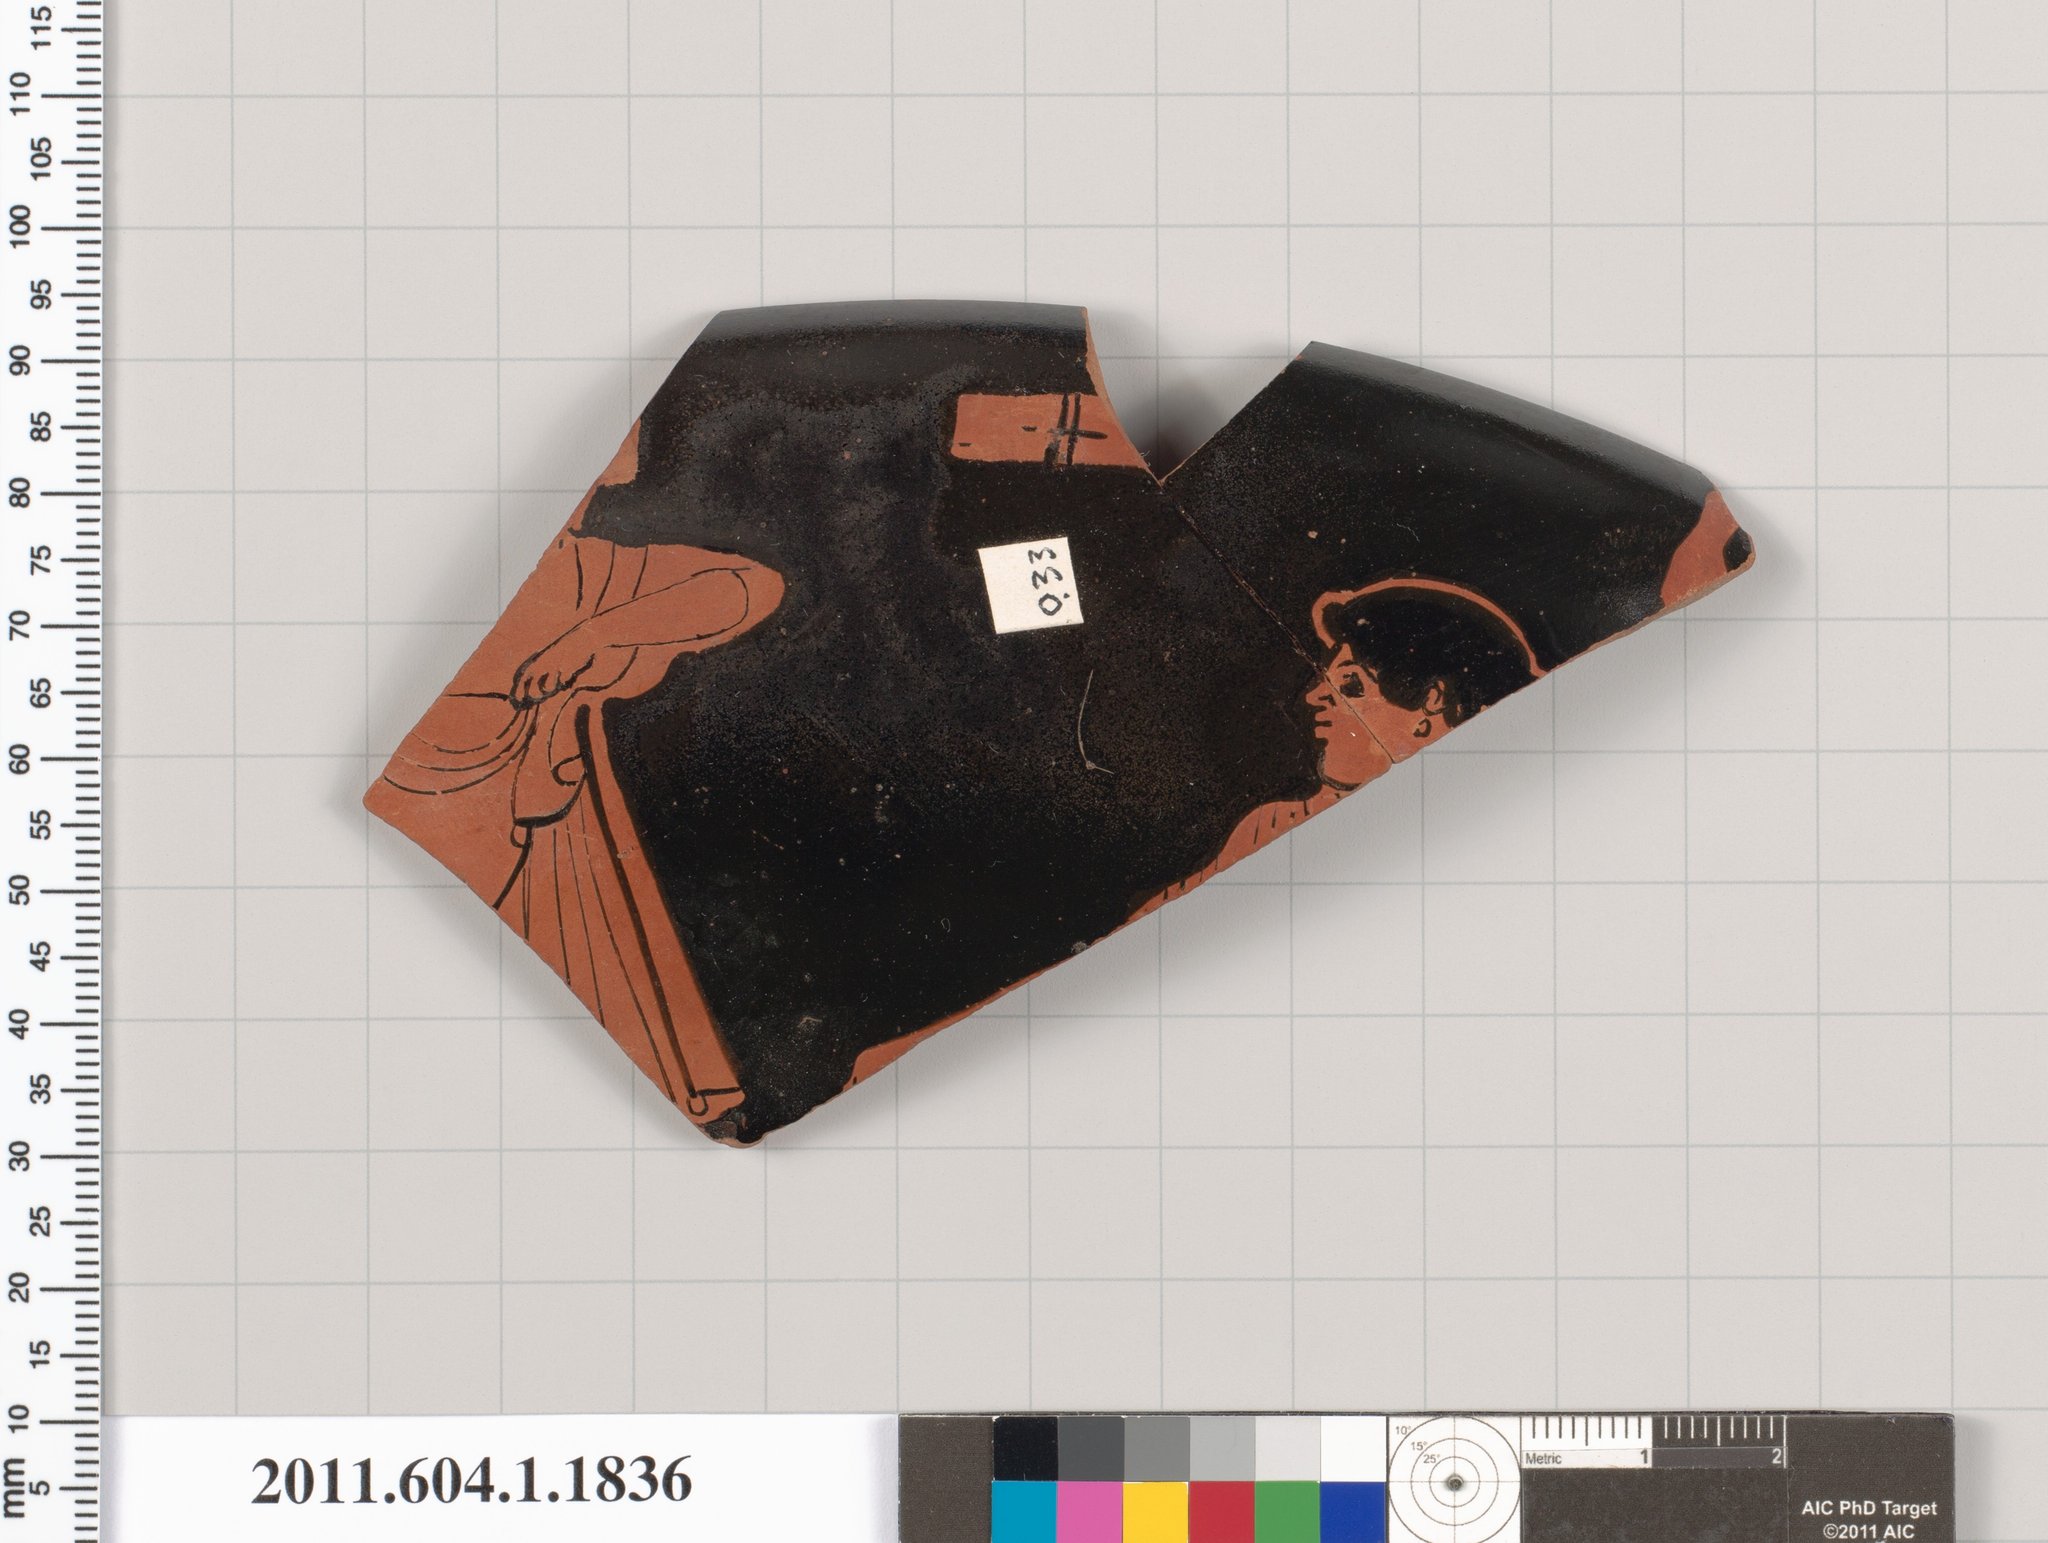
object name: kylix fragment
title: Terracotta rim fragment of a kylix (drinking cup)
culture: greek, attic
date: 475-451 BCE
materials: terracotta